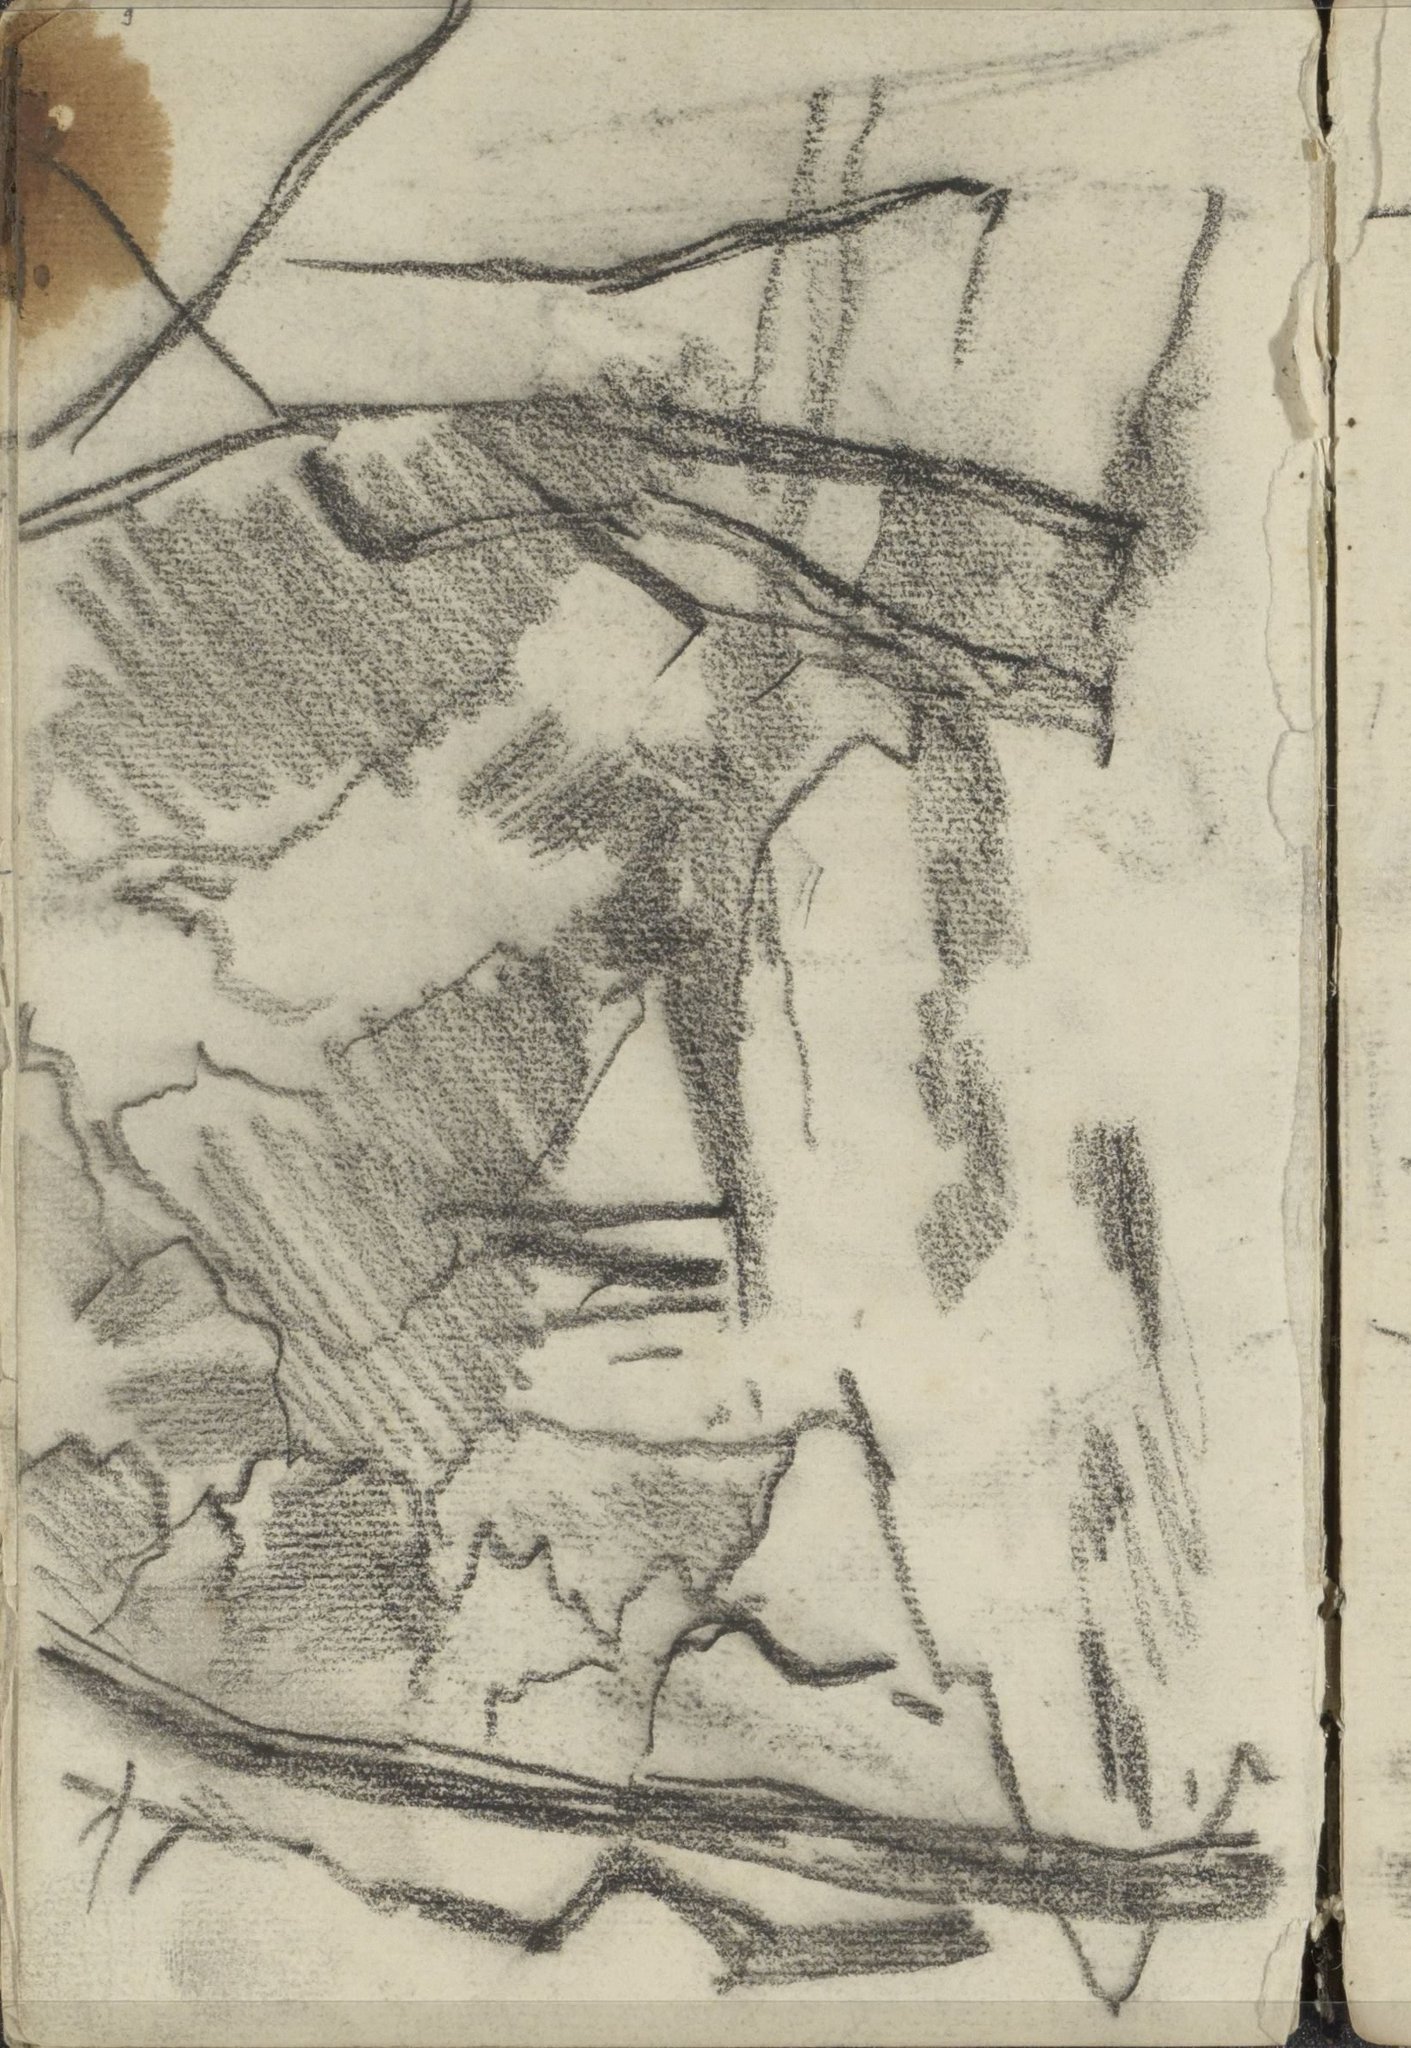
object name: sketchbook leaf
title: Landschap met bomen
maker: george hendrik breitner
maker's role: draughtsman, painter, print maker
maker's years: 1857-1923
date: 1887-1891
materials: chalk, paper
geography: amsterdam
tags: trees, landscapes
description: Pagina 9 uit een schetsboek met 17 bladen.